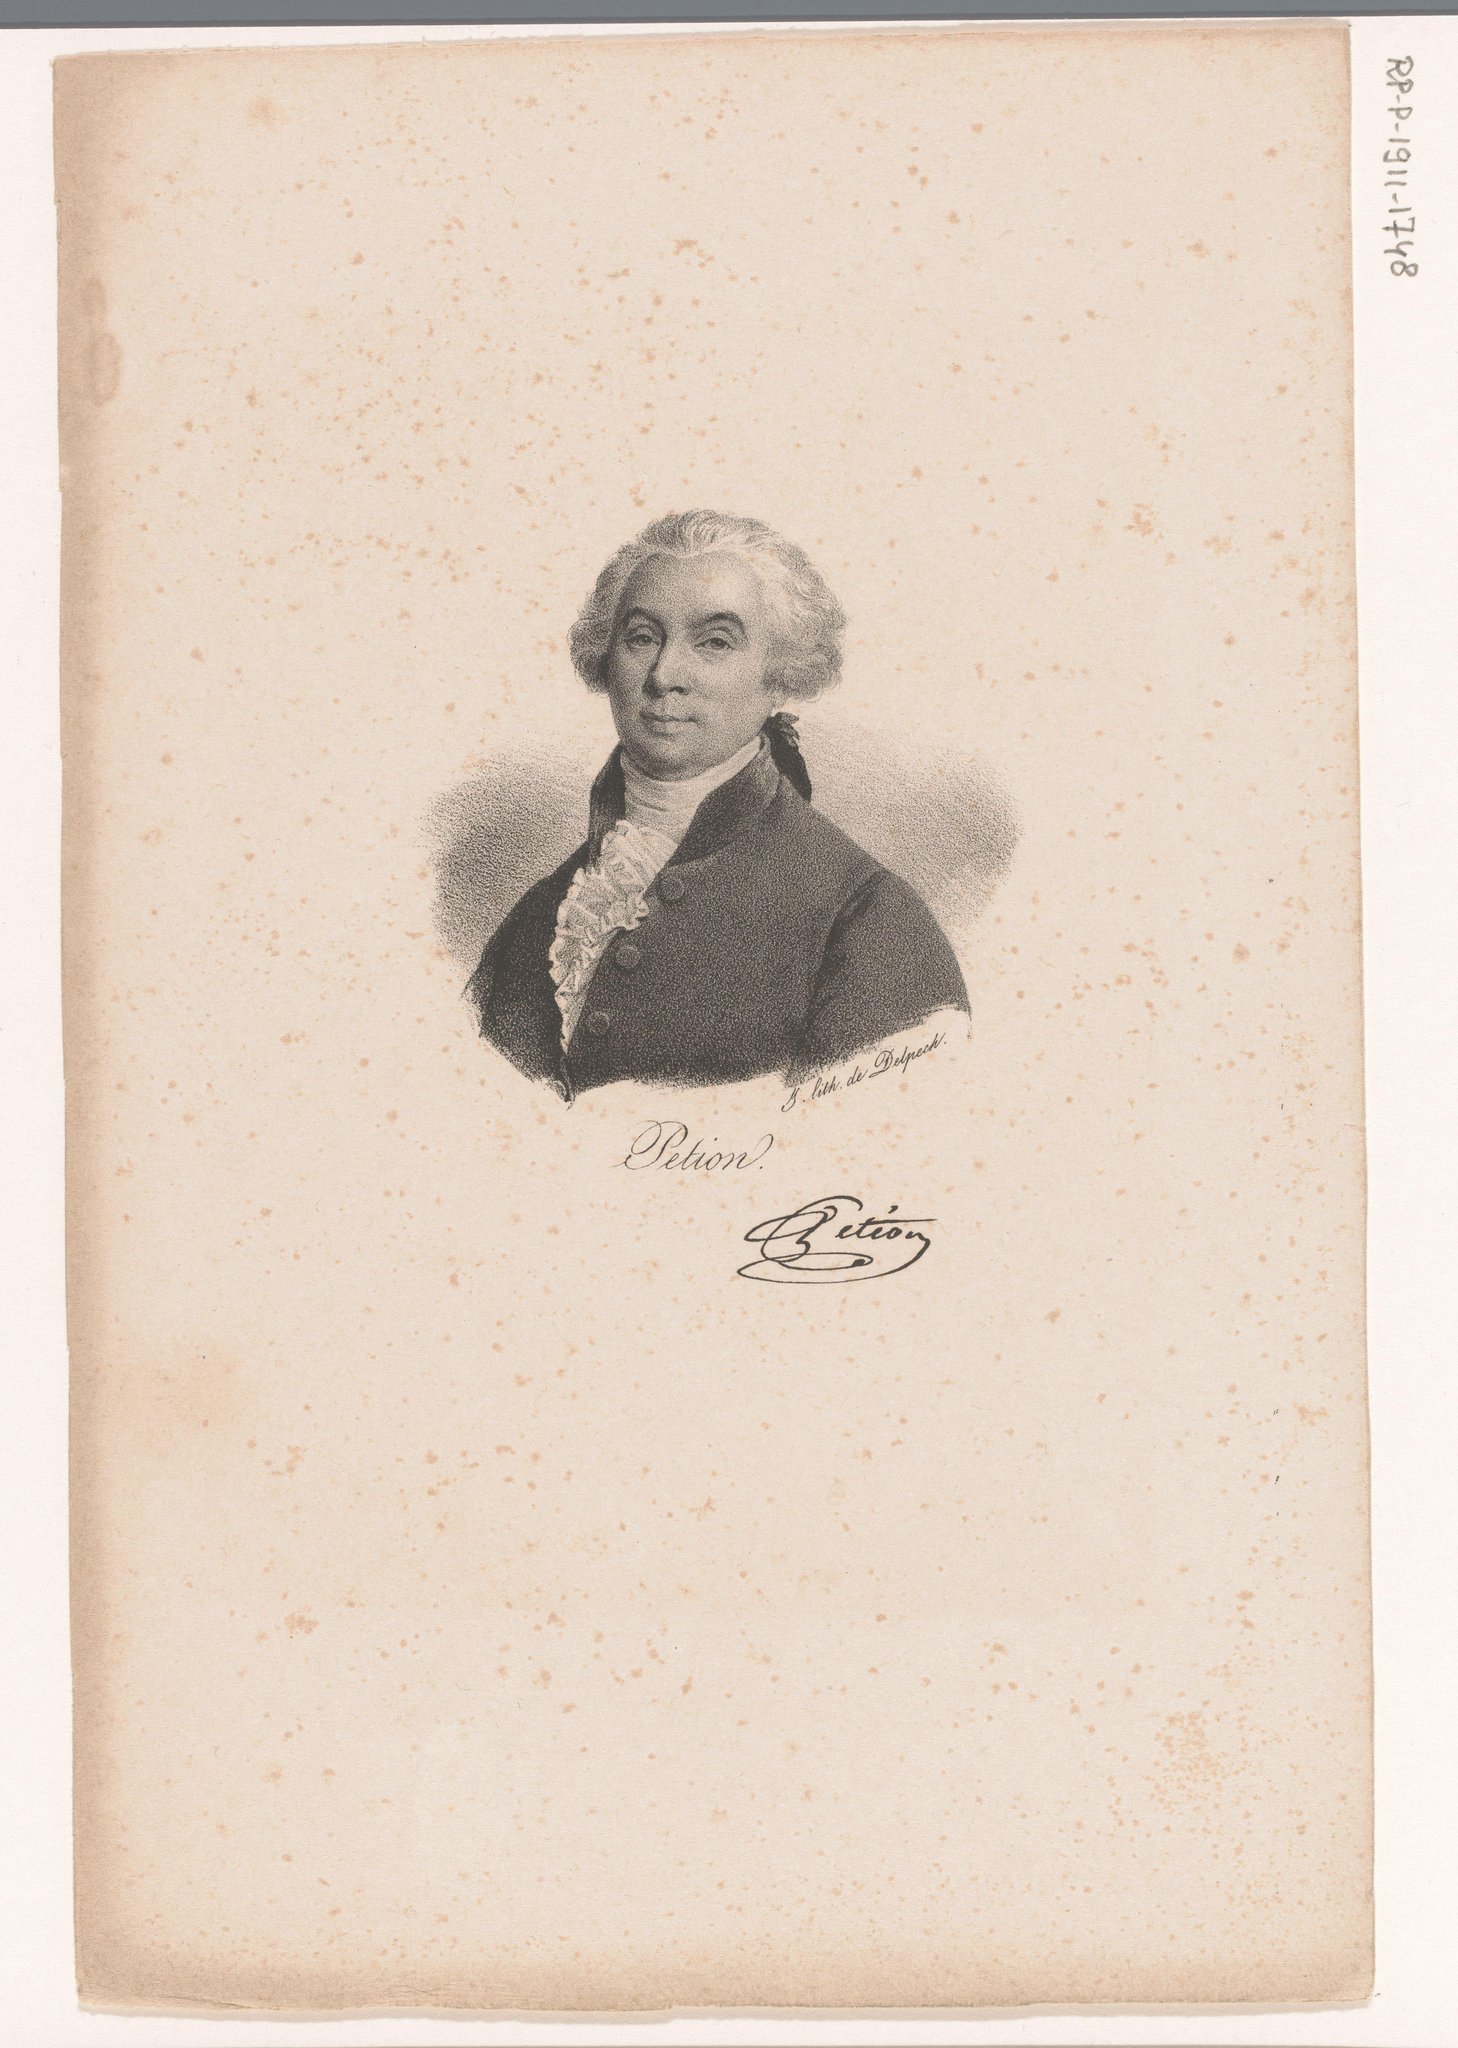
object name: print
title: Petion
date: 1818-1842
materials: paper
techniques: lithograph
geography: paris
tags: politician, historical persons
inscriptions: collector's mark: Lugt 2228a